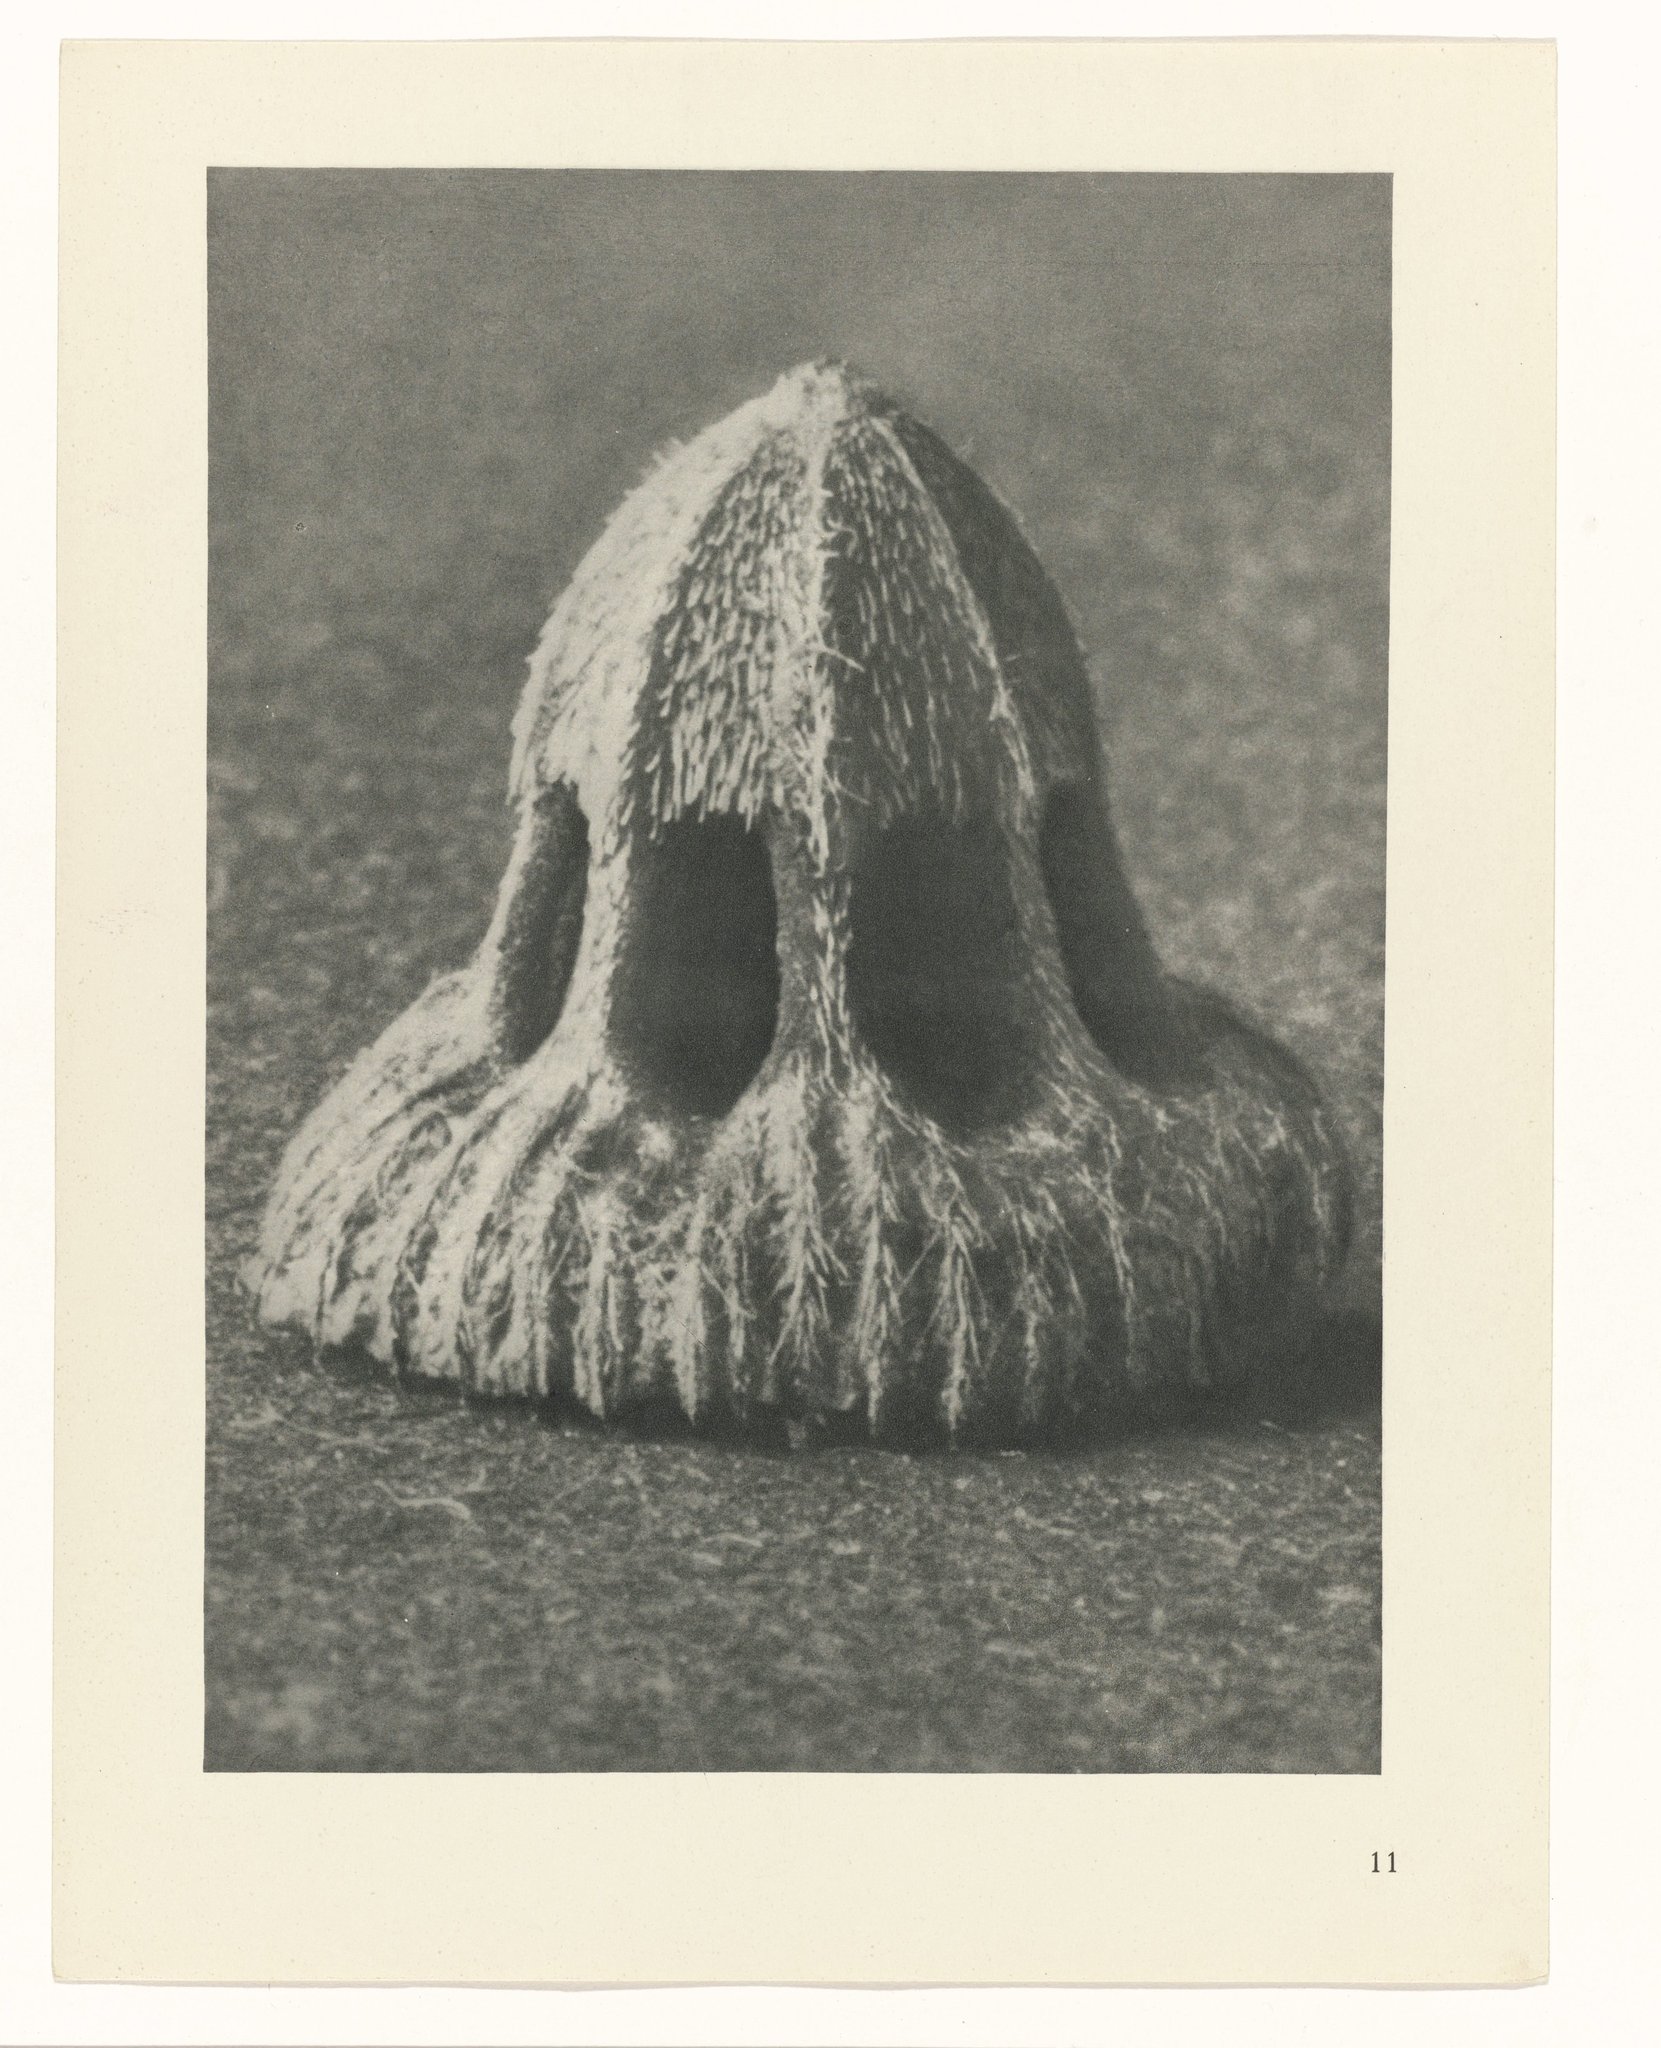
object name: photograph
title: Plant Studies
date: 1928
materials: ink, paper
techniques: rotogravure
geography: berlin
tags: plants (in general)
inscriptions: number: ‘11’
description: facher Vergrößerung. Afkomstig uit losbladige uitgave.